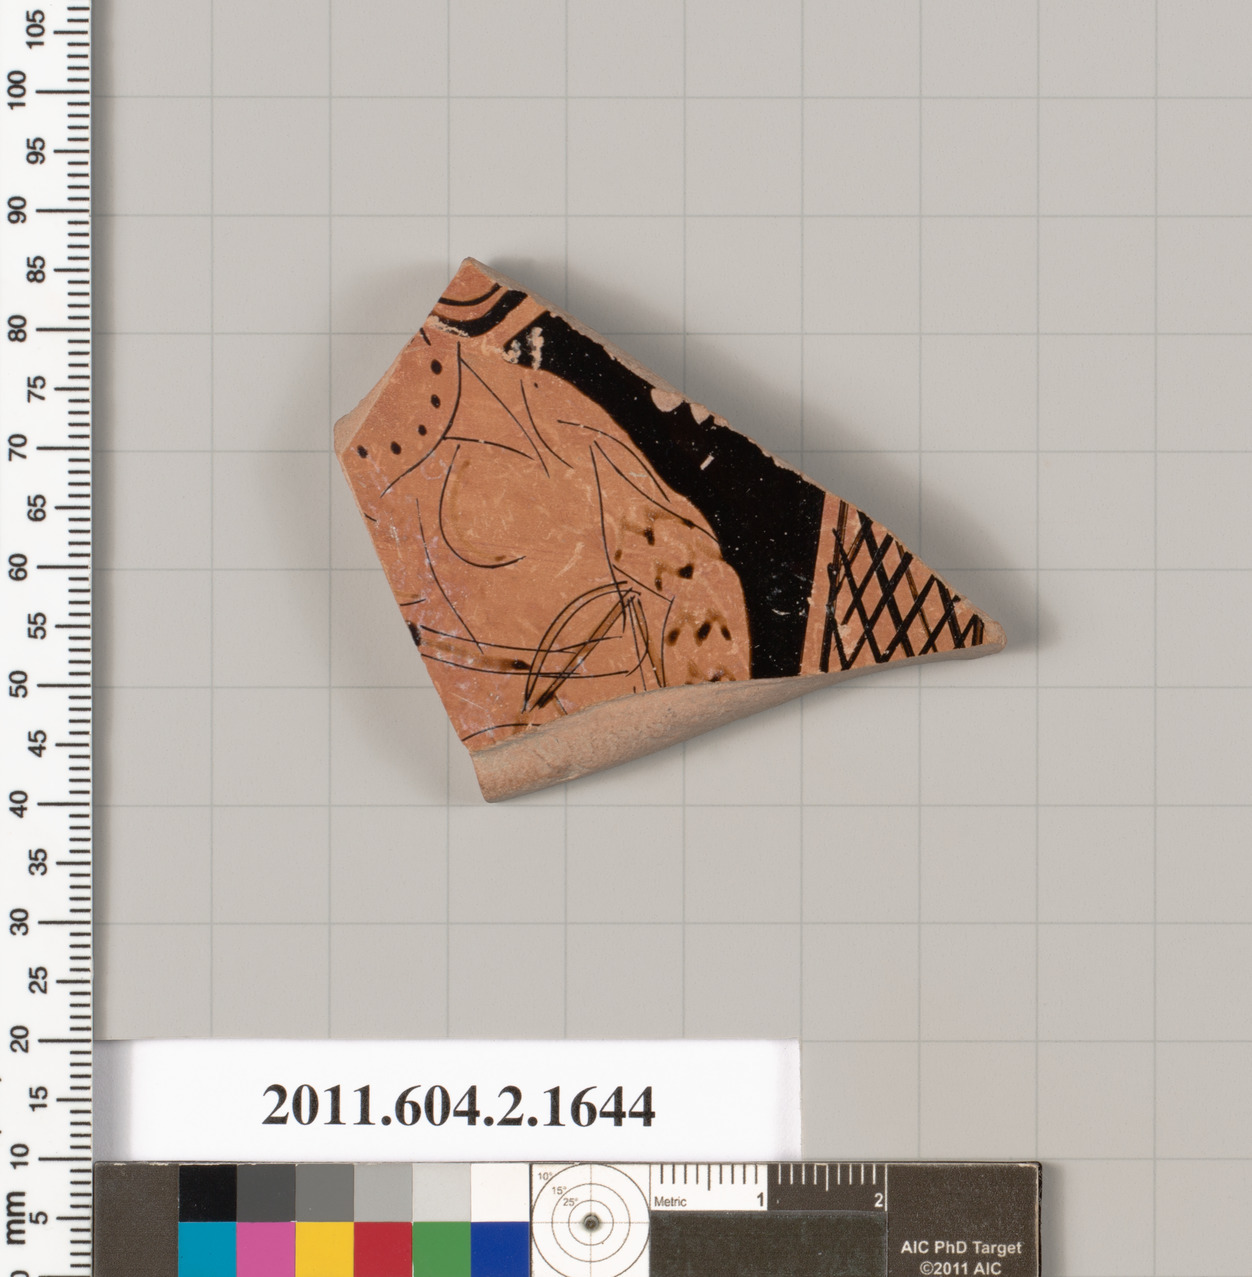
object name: skyphos fragment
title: Terracotta fragment of a skyphos (deep drinking cup)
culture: greek, attic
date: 425-401 BCE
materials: terracotta